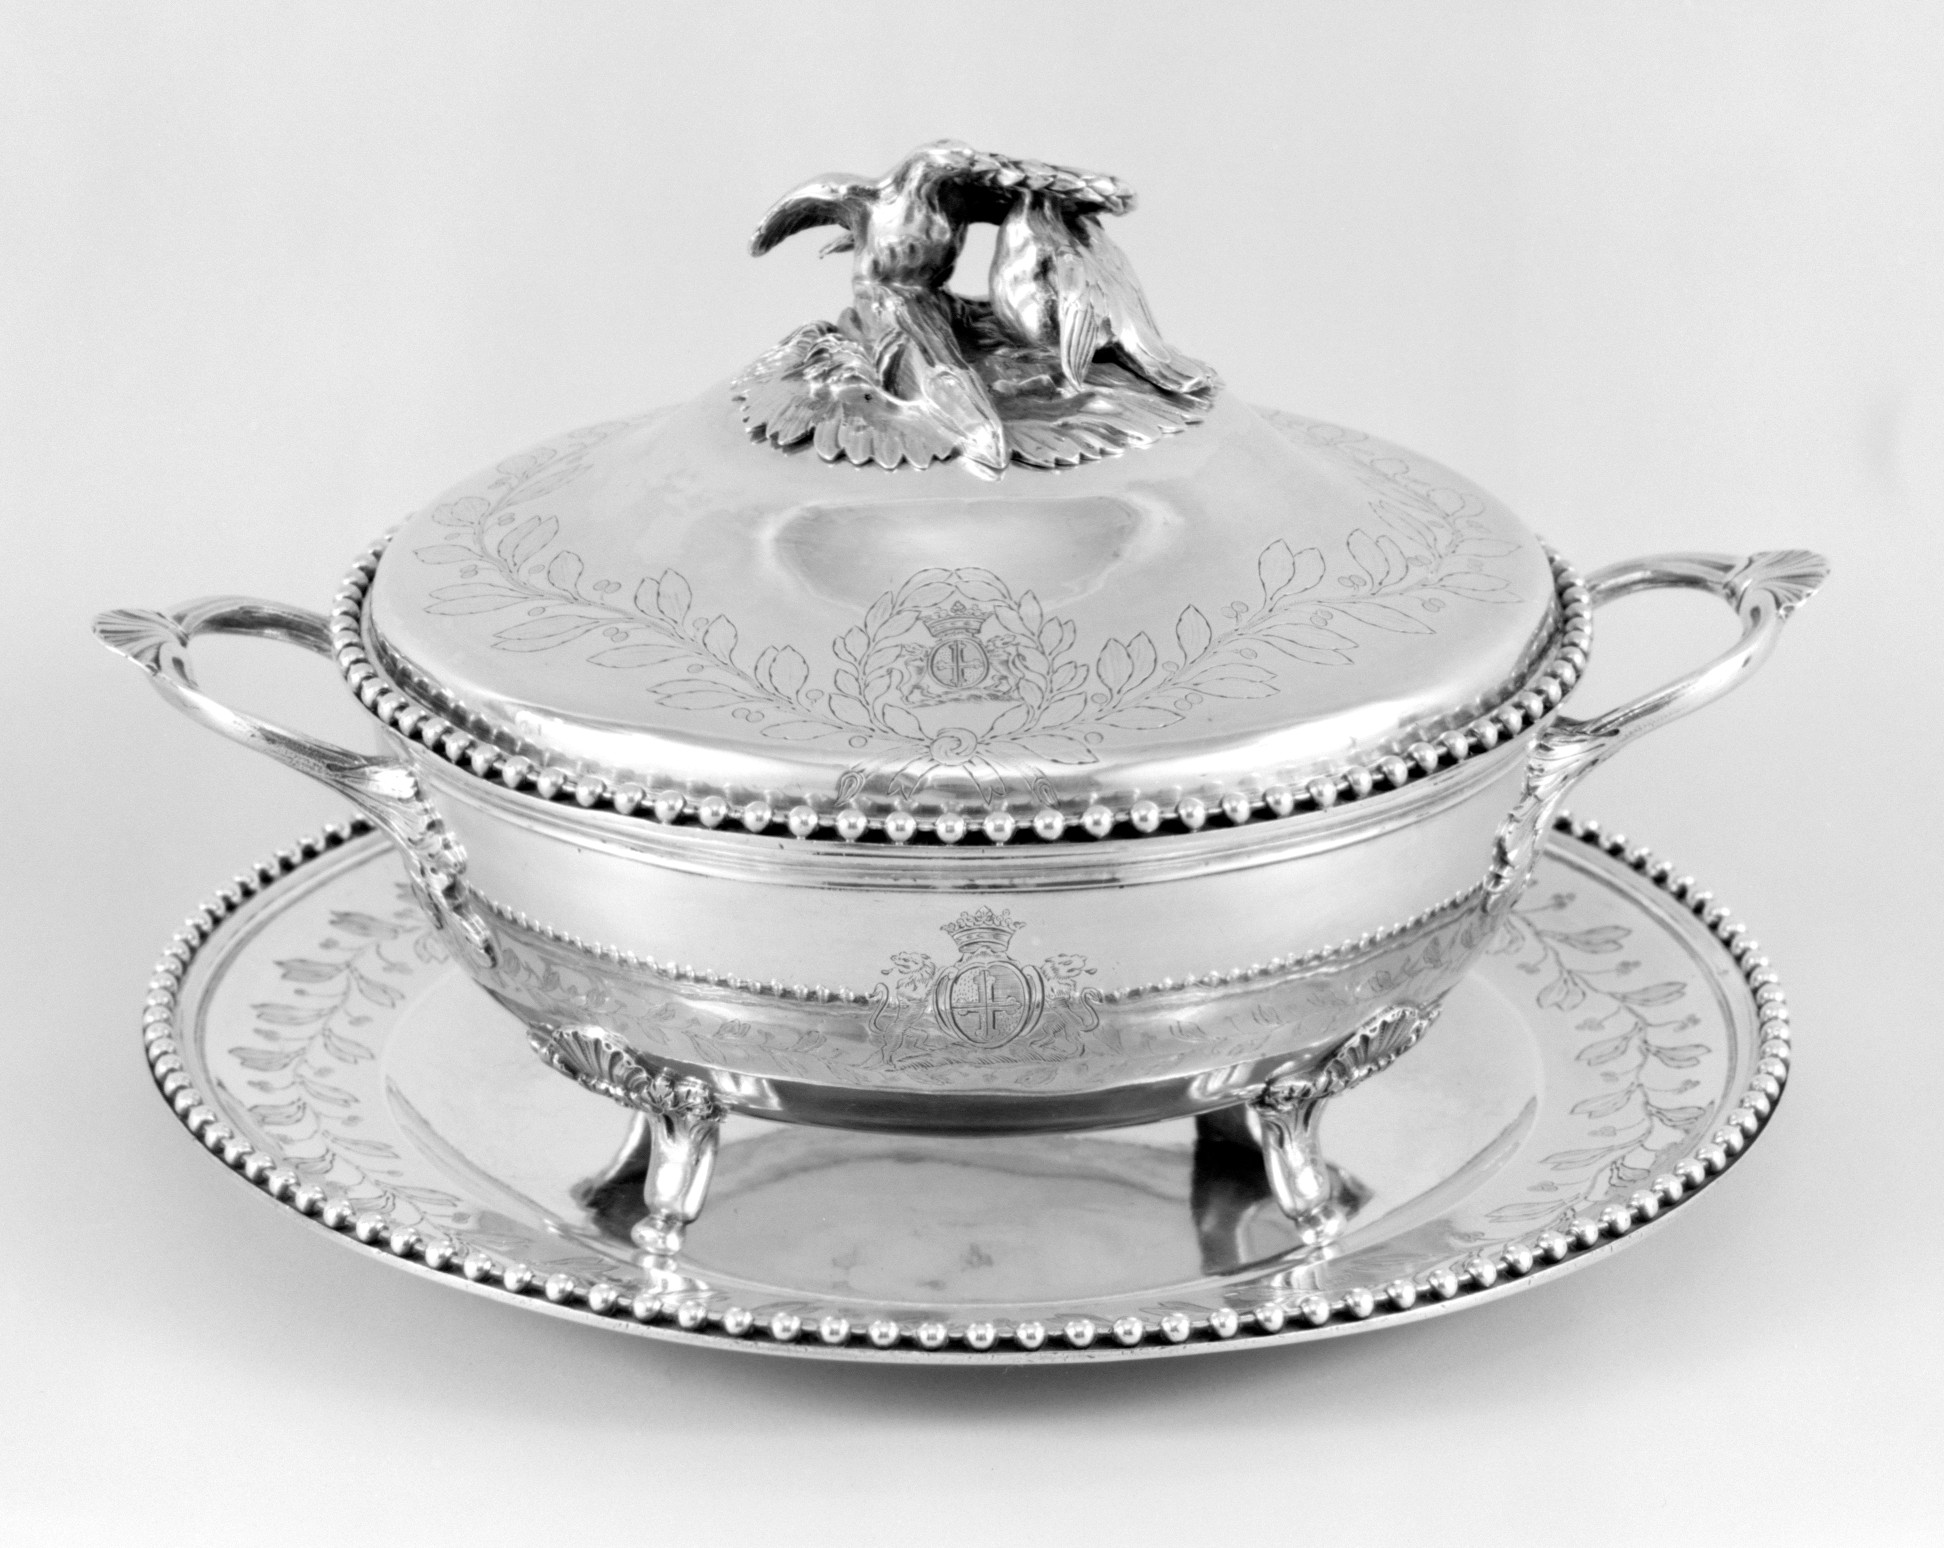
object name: vegetable dish with cover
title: Vegetable dish with cover and tray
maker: jean-françois-nicolas carron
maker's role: maker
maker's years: 1745-1836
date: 1781-1783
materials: silver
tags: birds,coat of arms